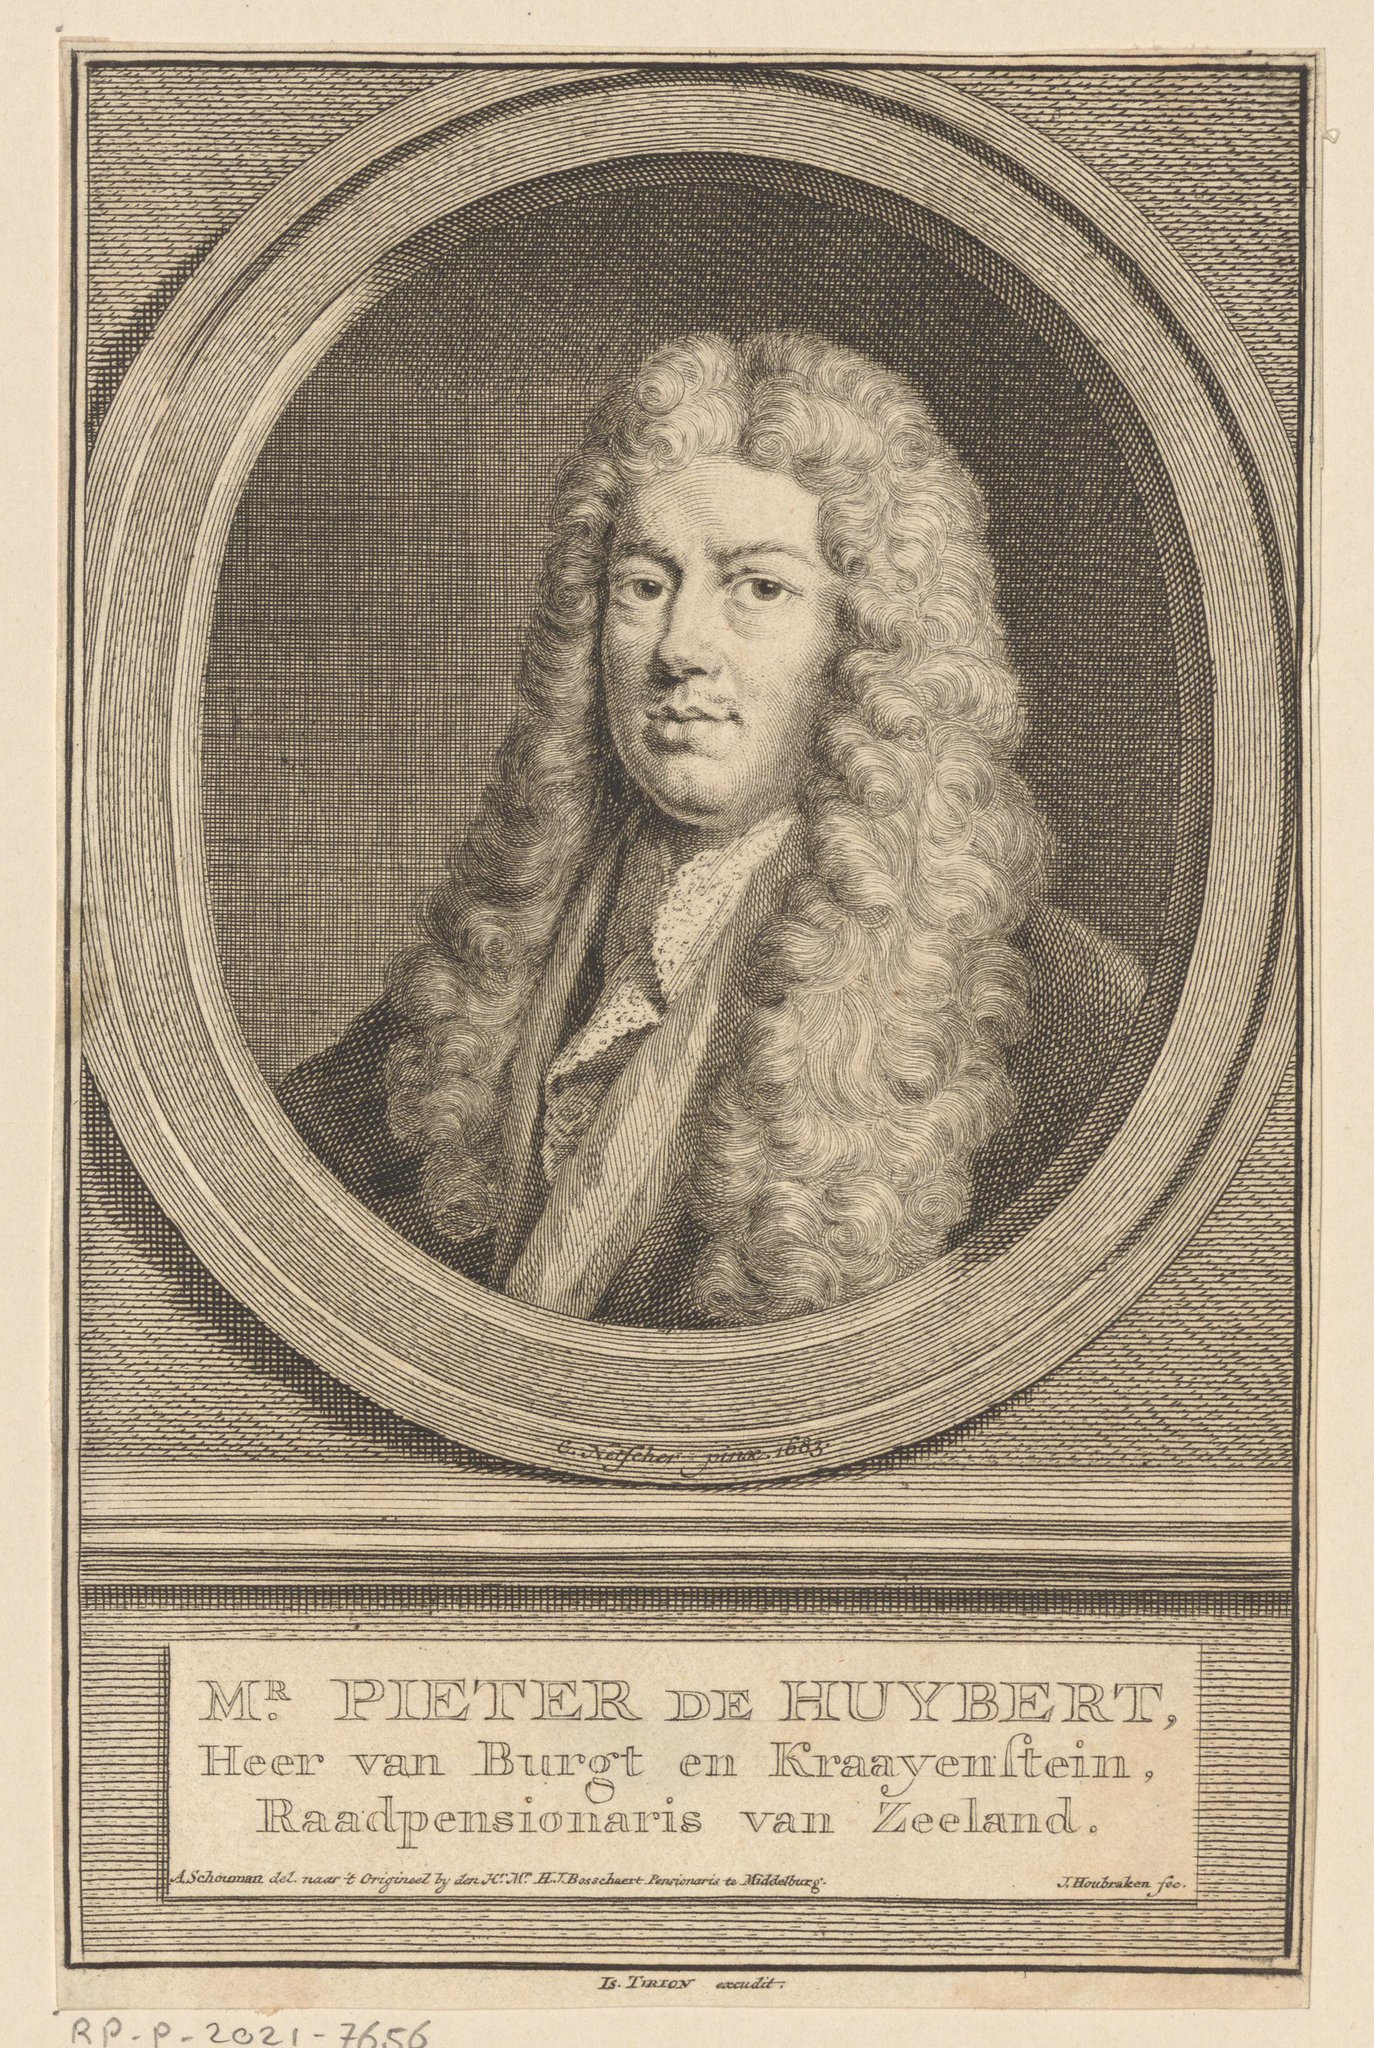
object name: print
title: Portret van Pieter de Huybert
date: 1749-1759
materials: paper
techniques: engraving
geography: amsterdam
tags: historical persons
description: Prent gebruikt in: Wagenaar, Jan. Vaderlandsche historie, vervattende de geschiedenissen der nu Vereenigde Nederlanden (...). 21 dln. Amsterdam: Isaak Tirion, 1749-1759, dl. 15. Prent ook gebruikt in latere edities van dit werk.